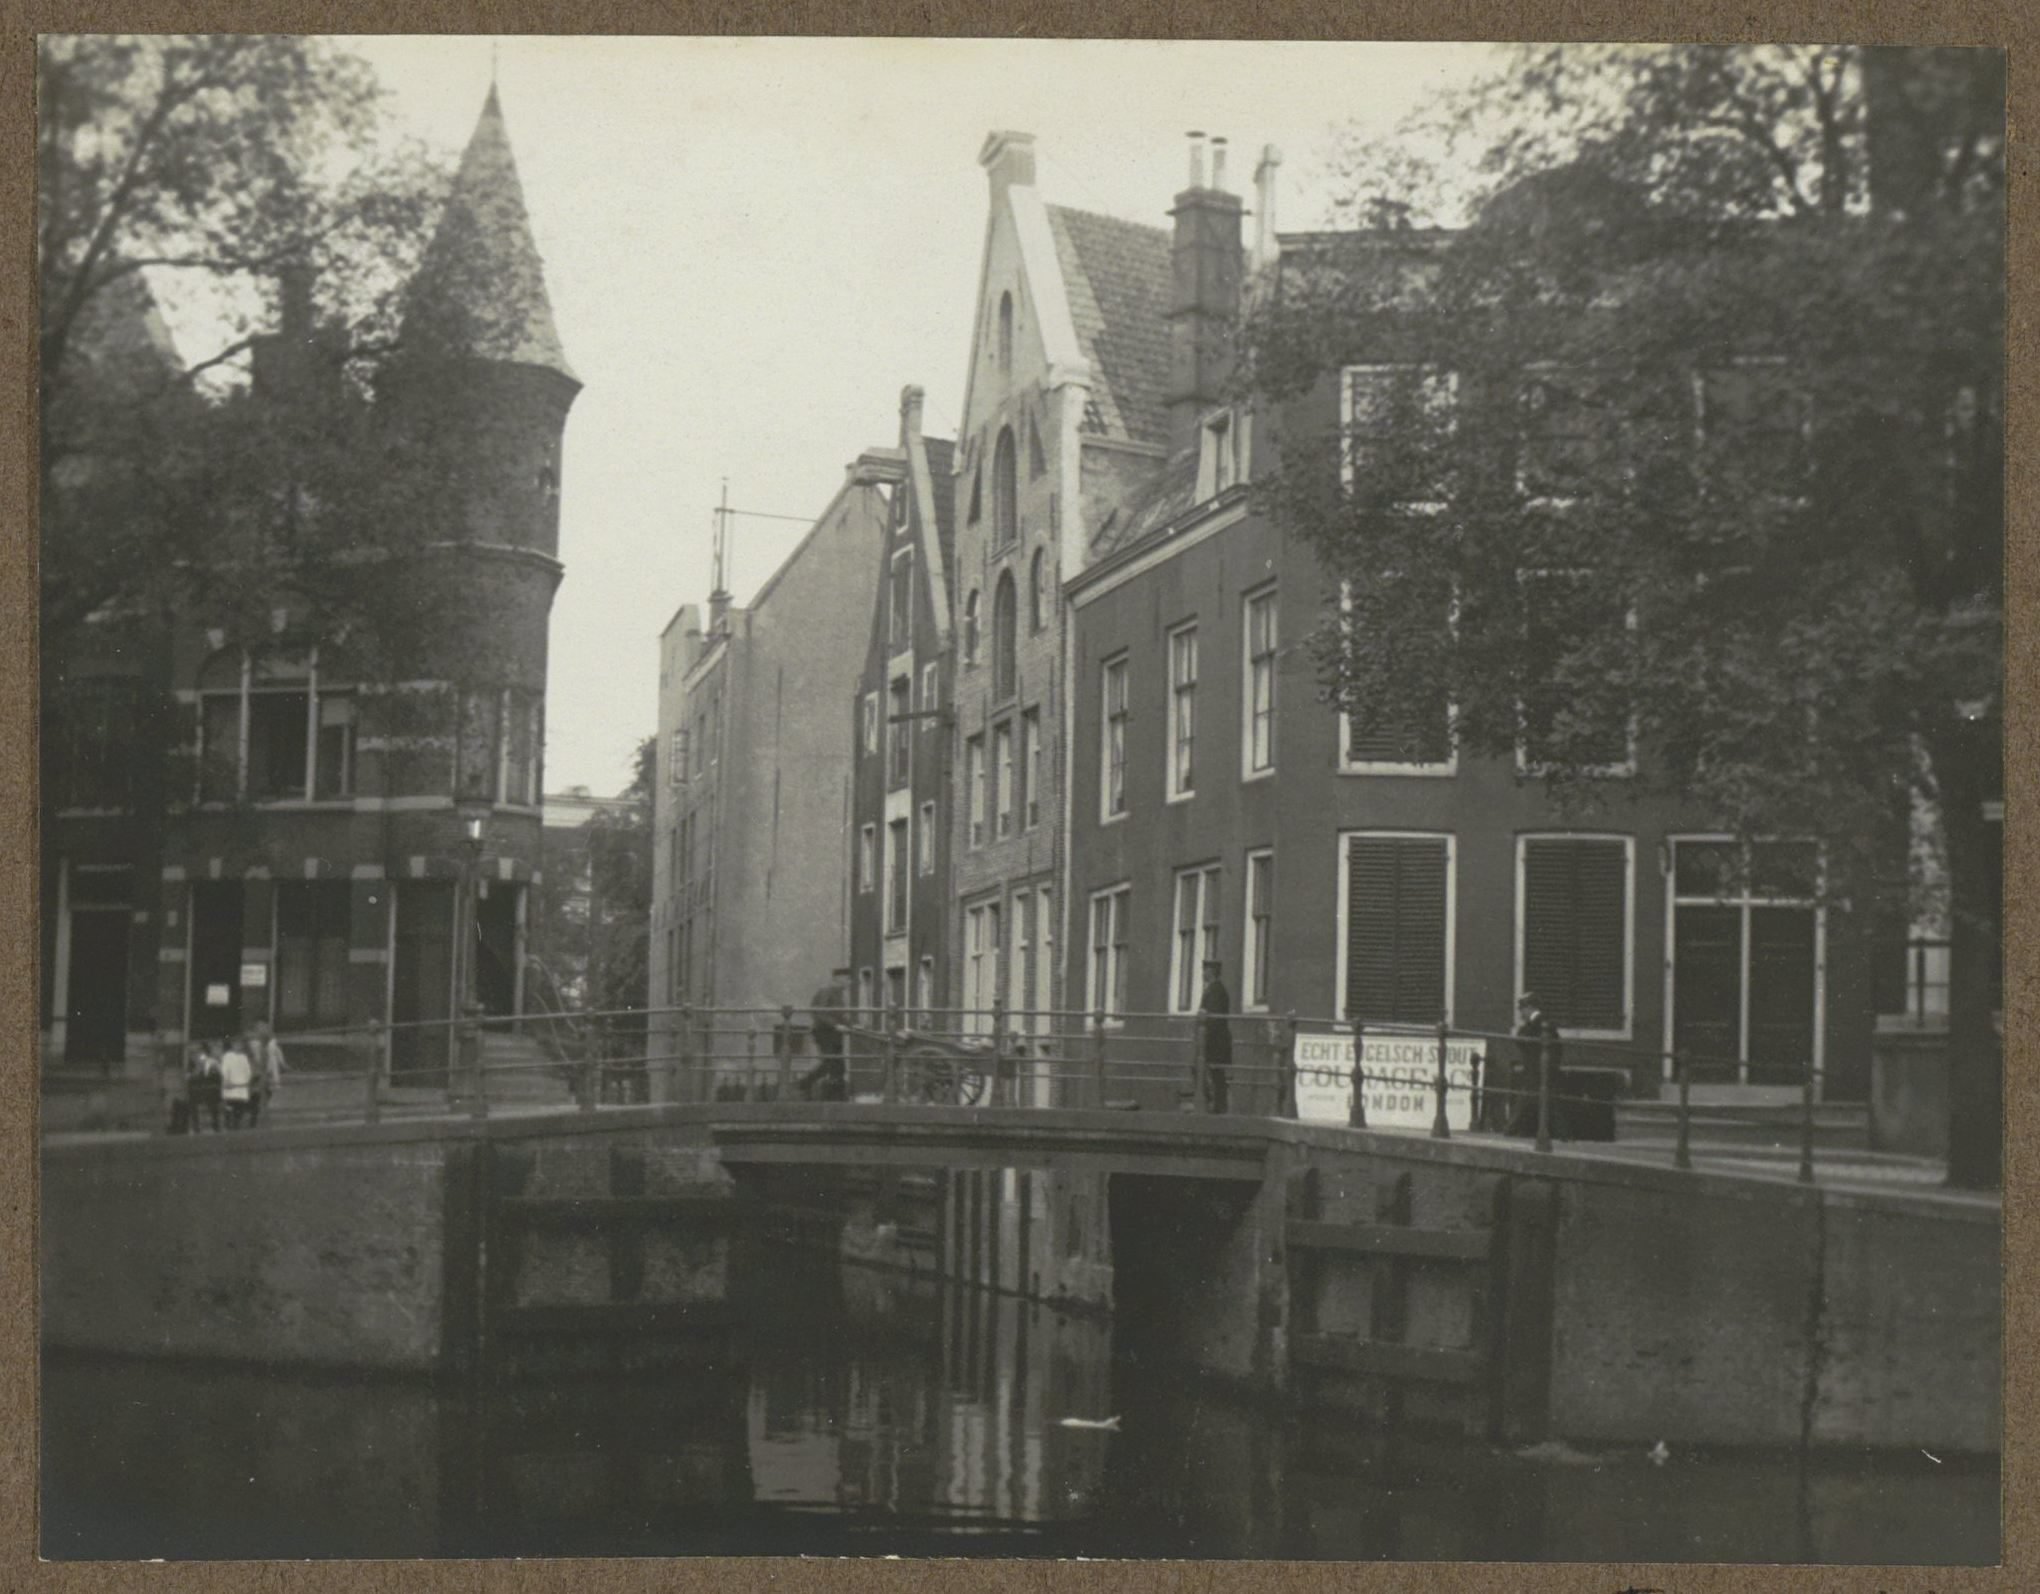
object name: photograph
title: Beulingsluis en de Beulingsloot in Amsterdam, gezien vanaf de Herengracht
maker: Anonymous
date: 1910-1930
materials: paper, photographic support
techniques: gelatin silver print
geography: amsterdam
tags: canal, sluice, weir (+ landscape with figures, staffage)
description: Onderdeel van Album met foto's van Amsterdam en omgeving.